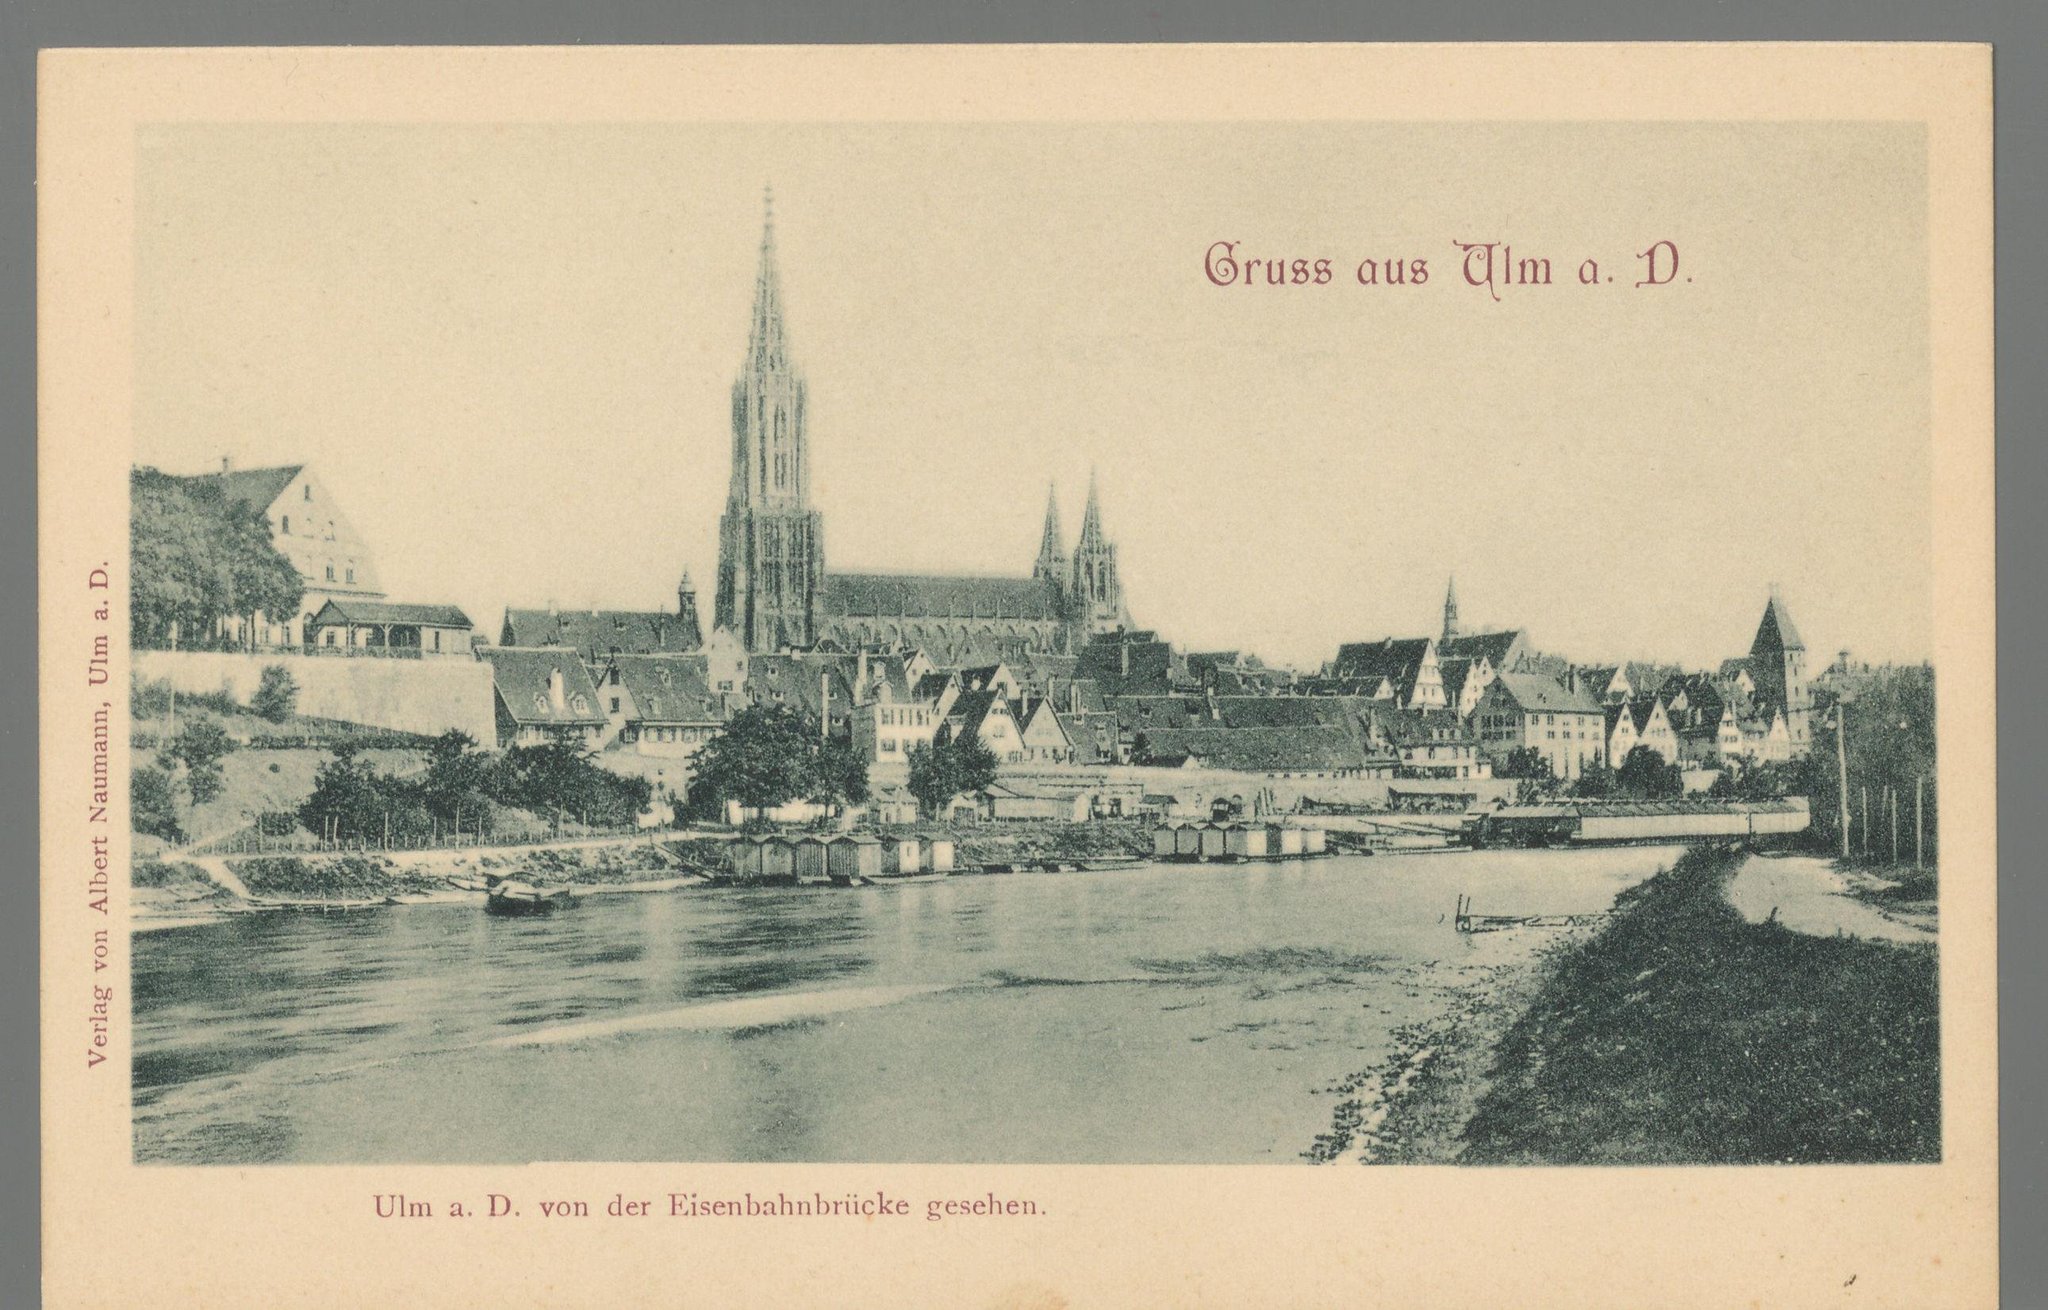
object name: photomechanical print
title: Gruss aus Ulm a. D. Ulm a. D. von der Eisenbahnbrücke gesehen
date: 1885-1905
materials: cardboard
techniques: photograph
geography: ulm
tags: church (exterior), canals, waters (in city)